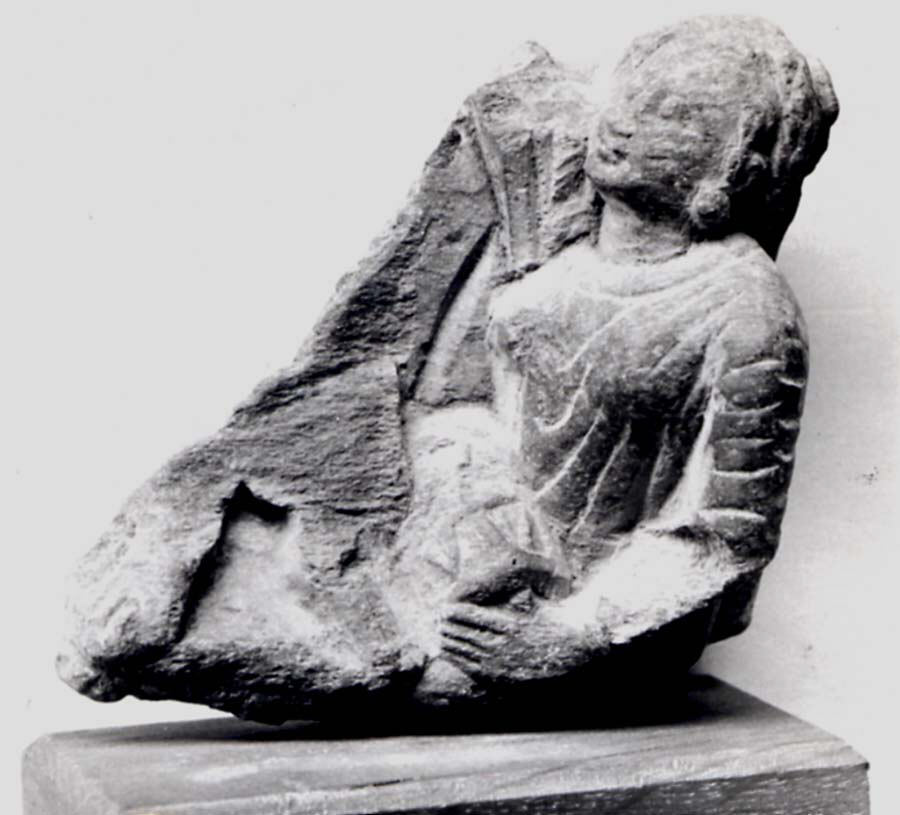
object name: relief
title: Seated Female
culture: gandhara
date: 1-300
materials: stone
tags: gandhara,women